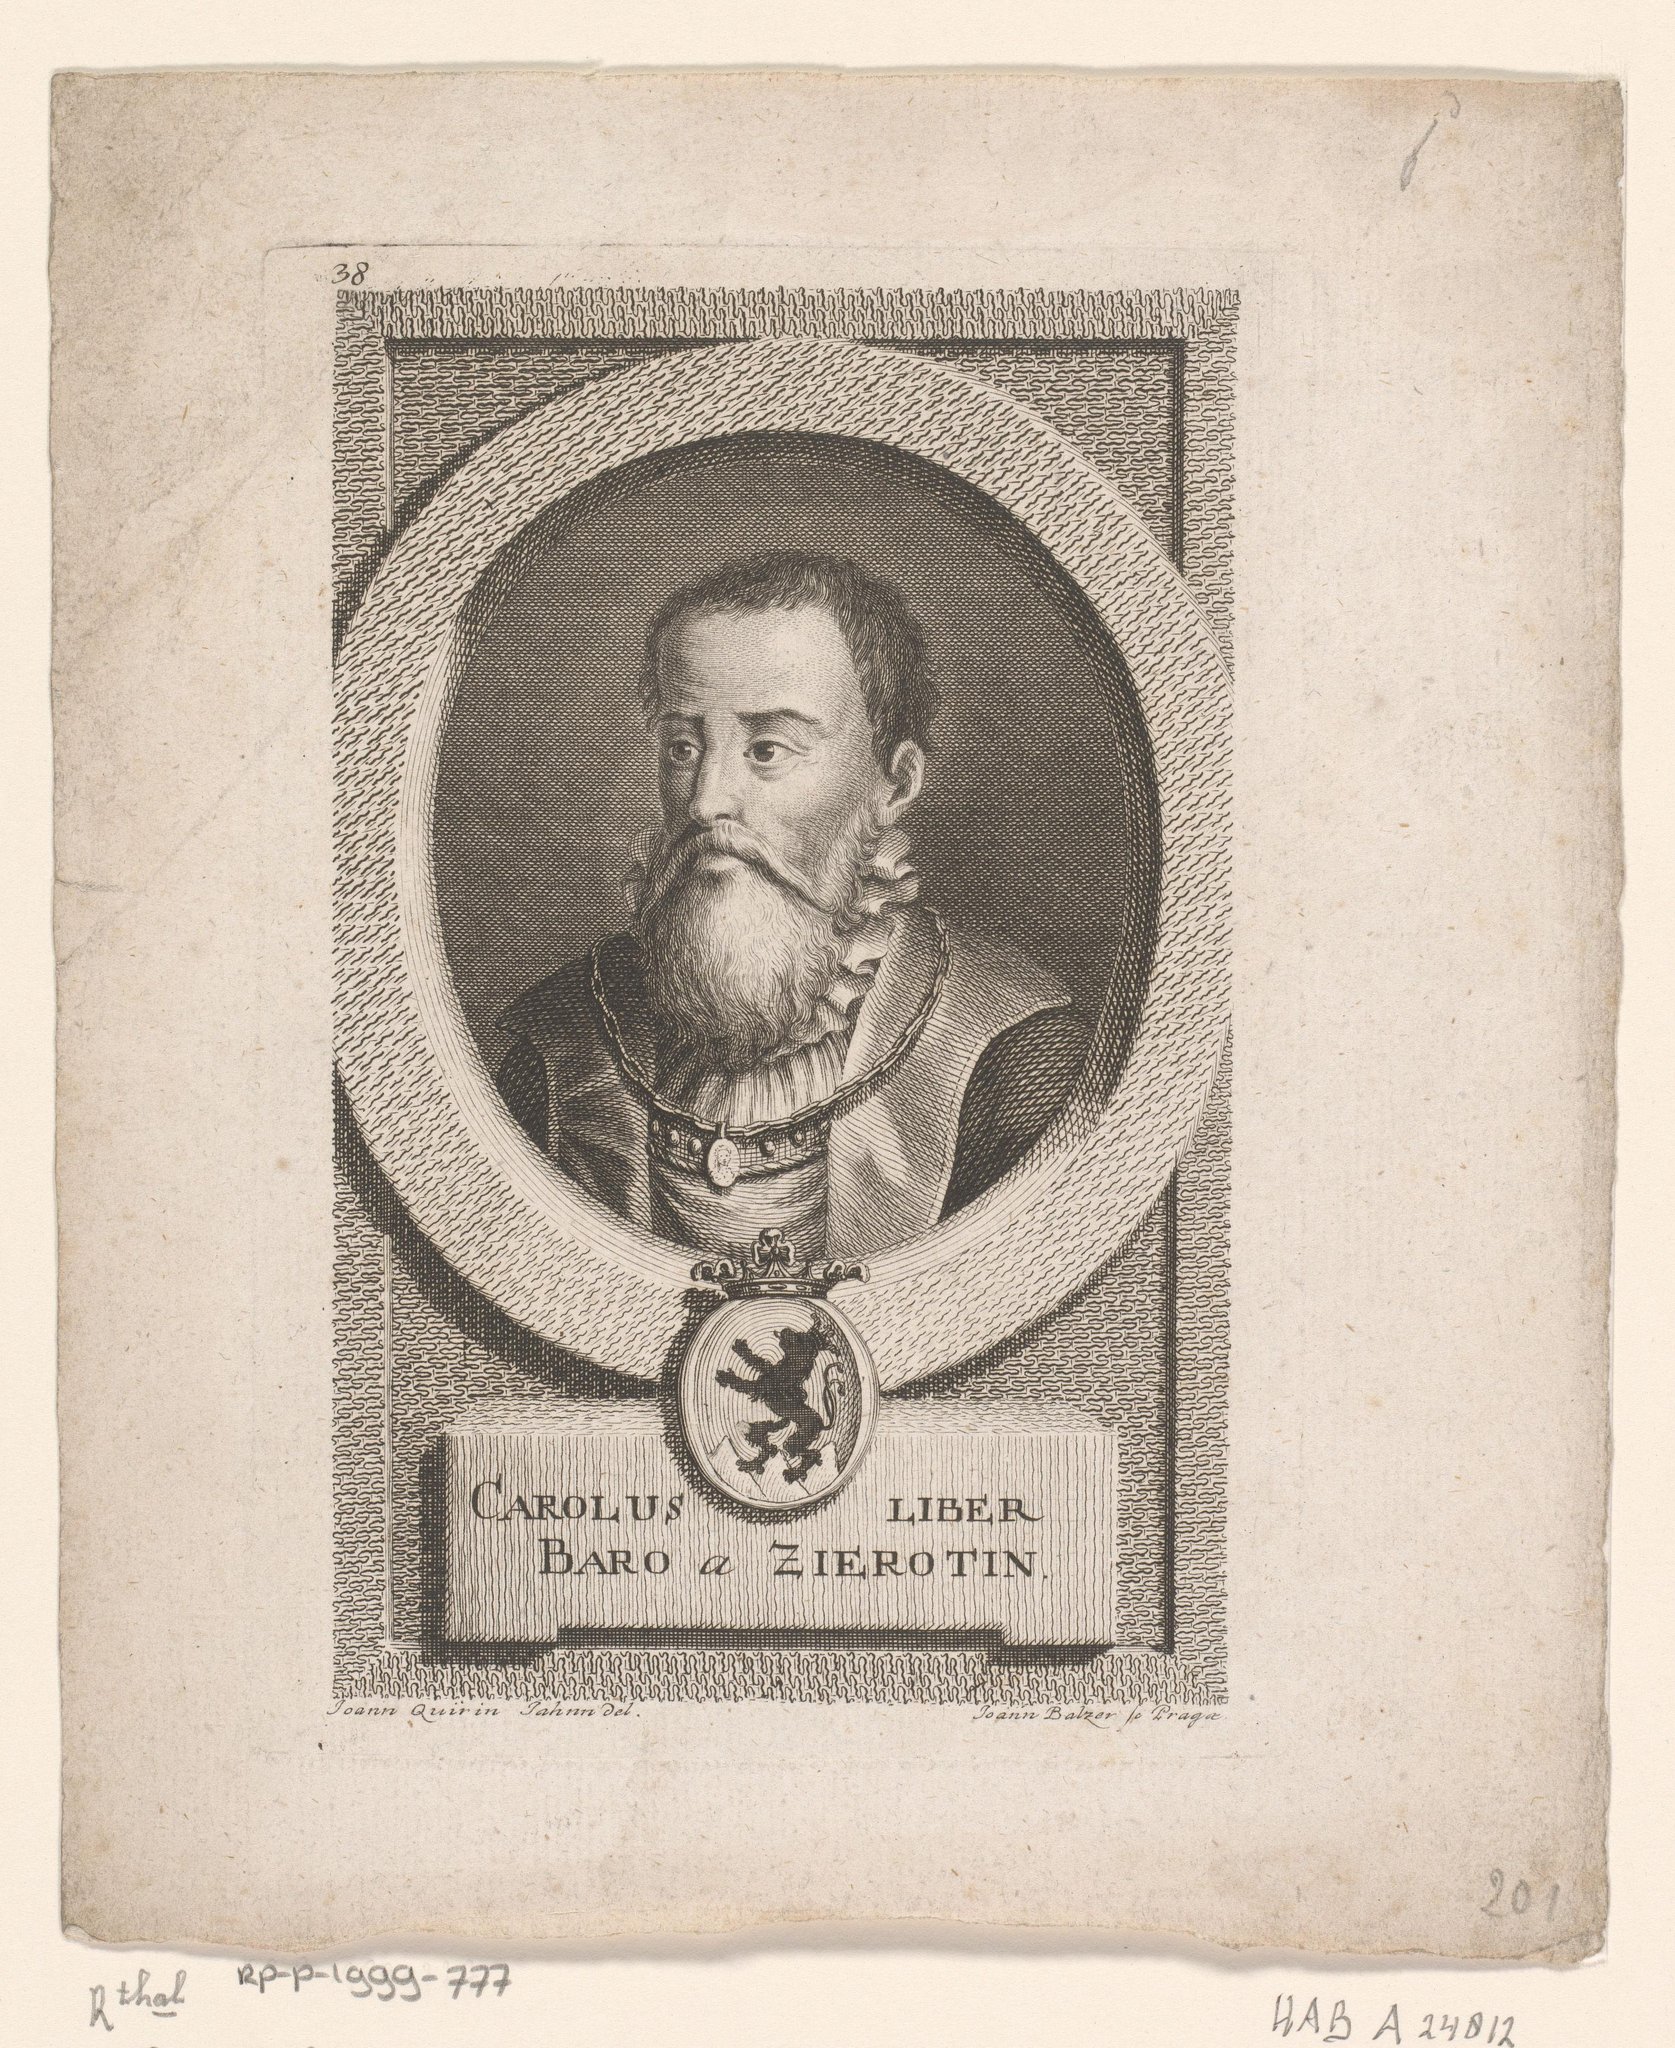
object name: print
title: Carolus Liber Baro a Zierotin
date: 1860-1885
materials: paper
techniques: engraving, etching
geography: prague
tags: historical persons, politician, e.g. party leader, armorial bearing, heraldry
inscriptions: collector's mark: Lugt 2228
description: Eerste staat van deze prent mogelijk gebruikt in: Schweinitz, Edmund de. The History of the Church Known as the Unitas Fratrum: Or the Unity of the Brethren, Founded by the Followers of John Hus, the Bohemian Reformer and Martyr. Moravië: s.n., 1885.